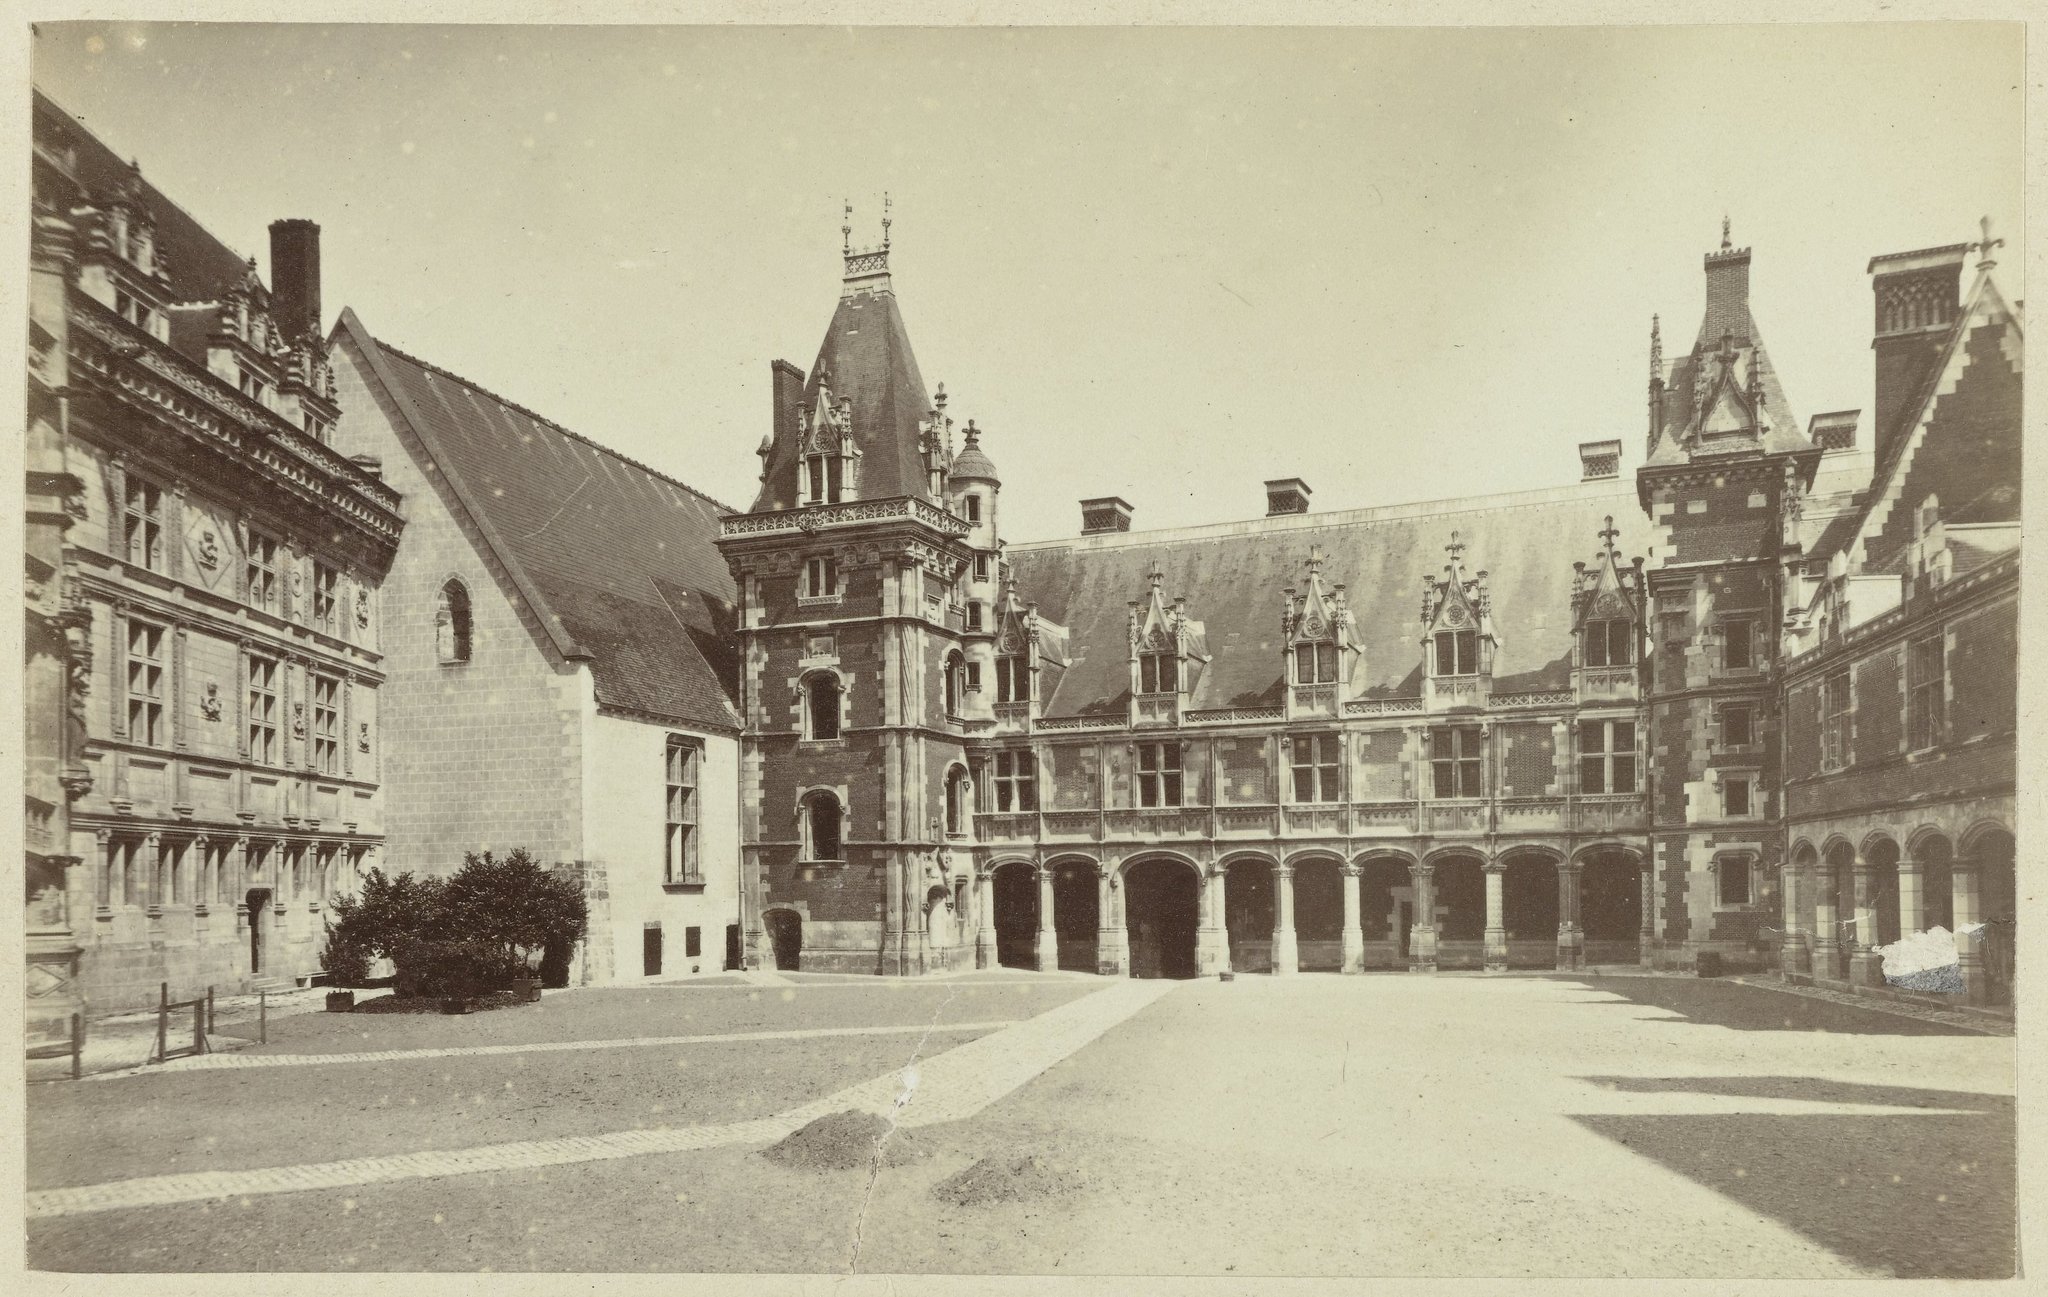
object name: photograph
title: Binnenplaats van het kasteel van Blois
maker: Anonymous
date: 1865-1875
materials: cardboard, paper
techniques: albumen print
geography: château de blois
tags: palace, façade of inner court, inner court of palace or 'hôtel'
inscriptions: inscription: ‘BLOIS’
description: De binnenplaats van het kasteel van Blois gezien richting de vleugel van Lodewijk XII.